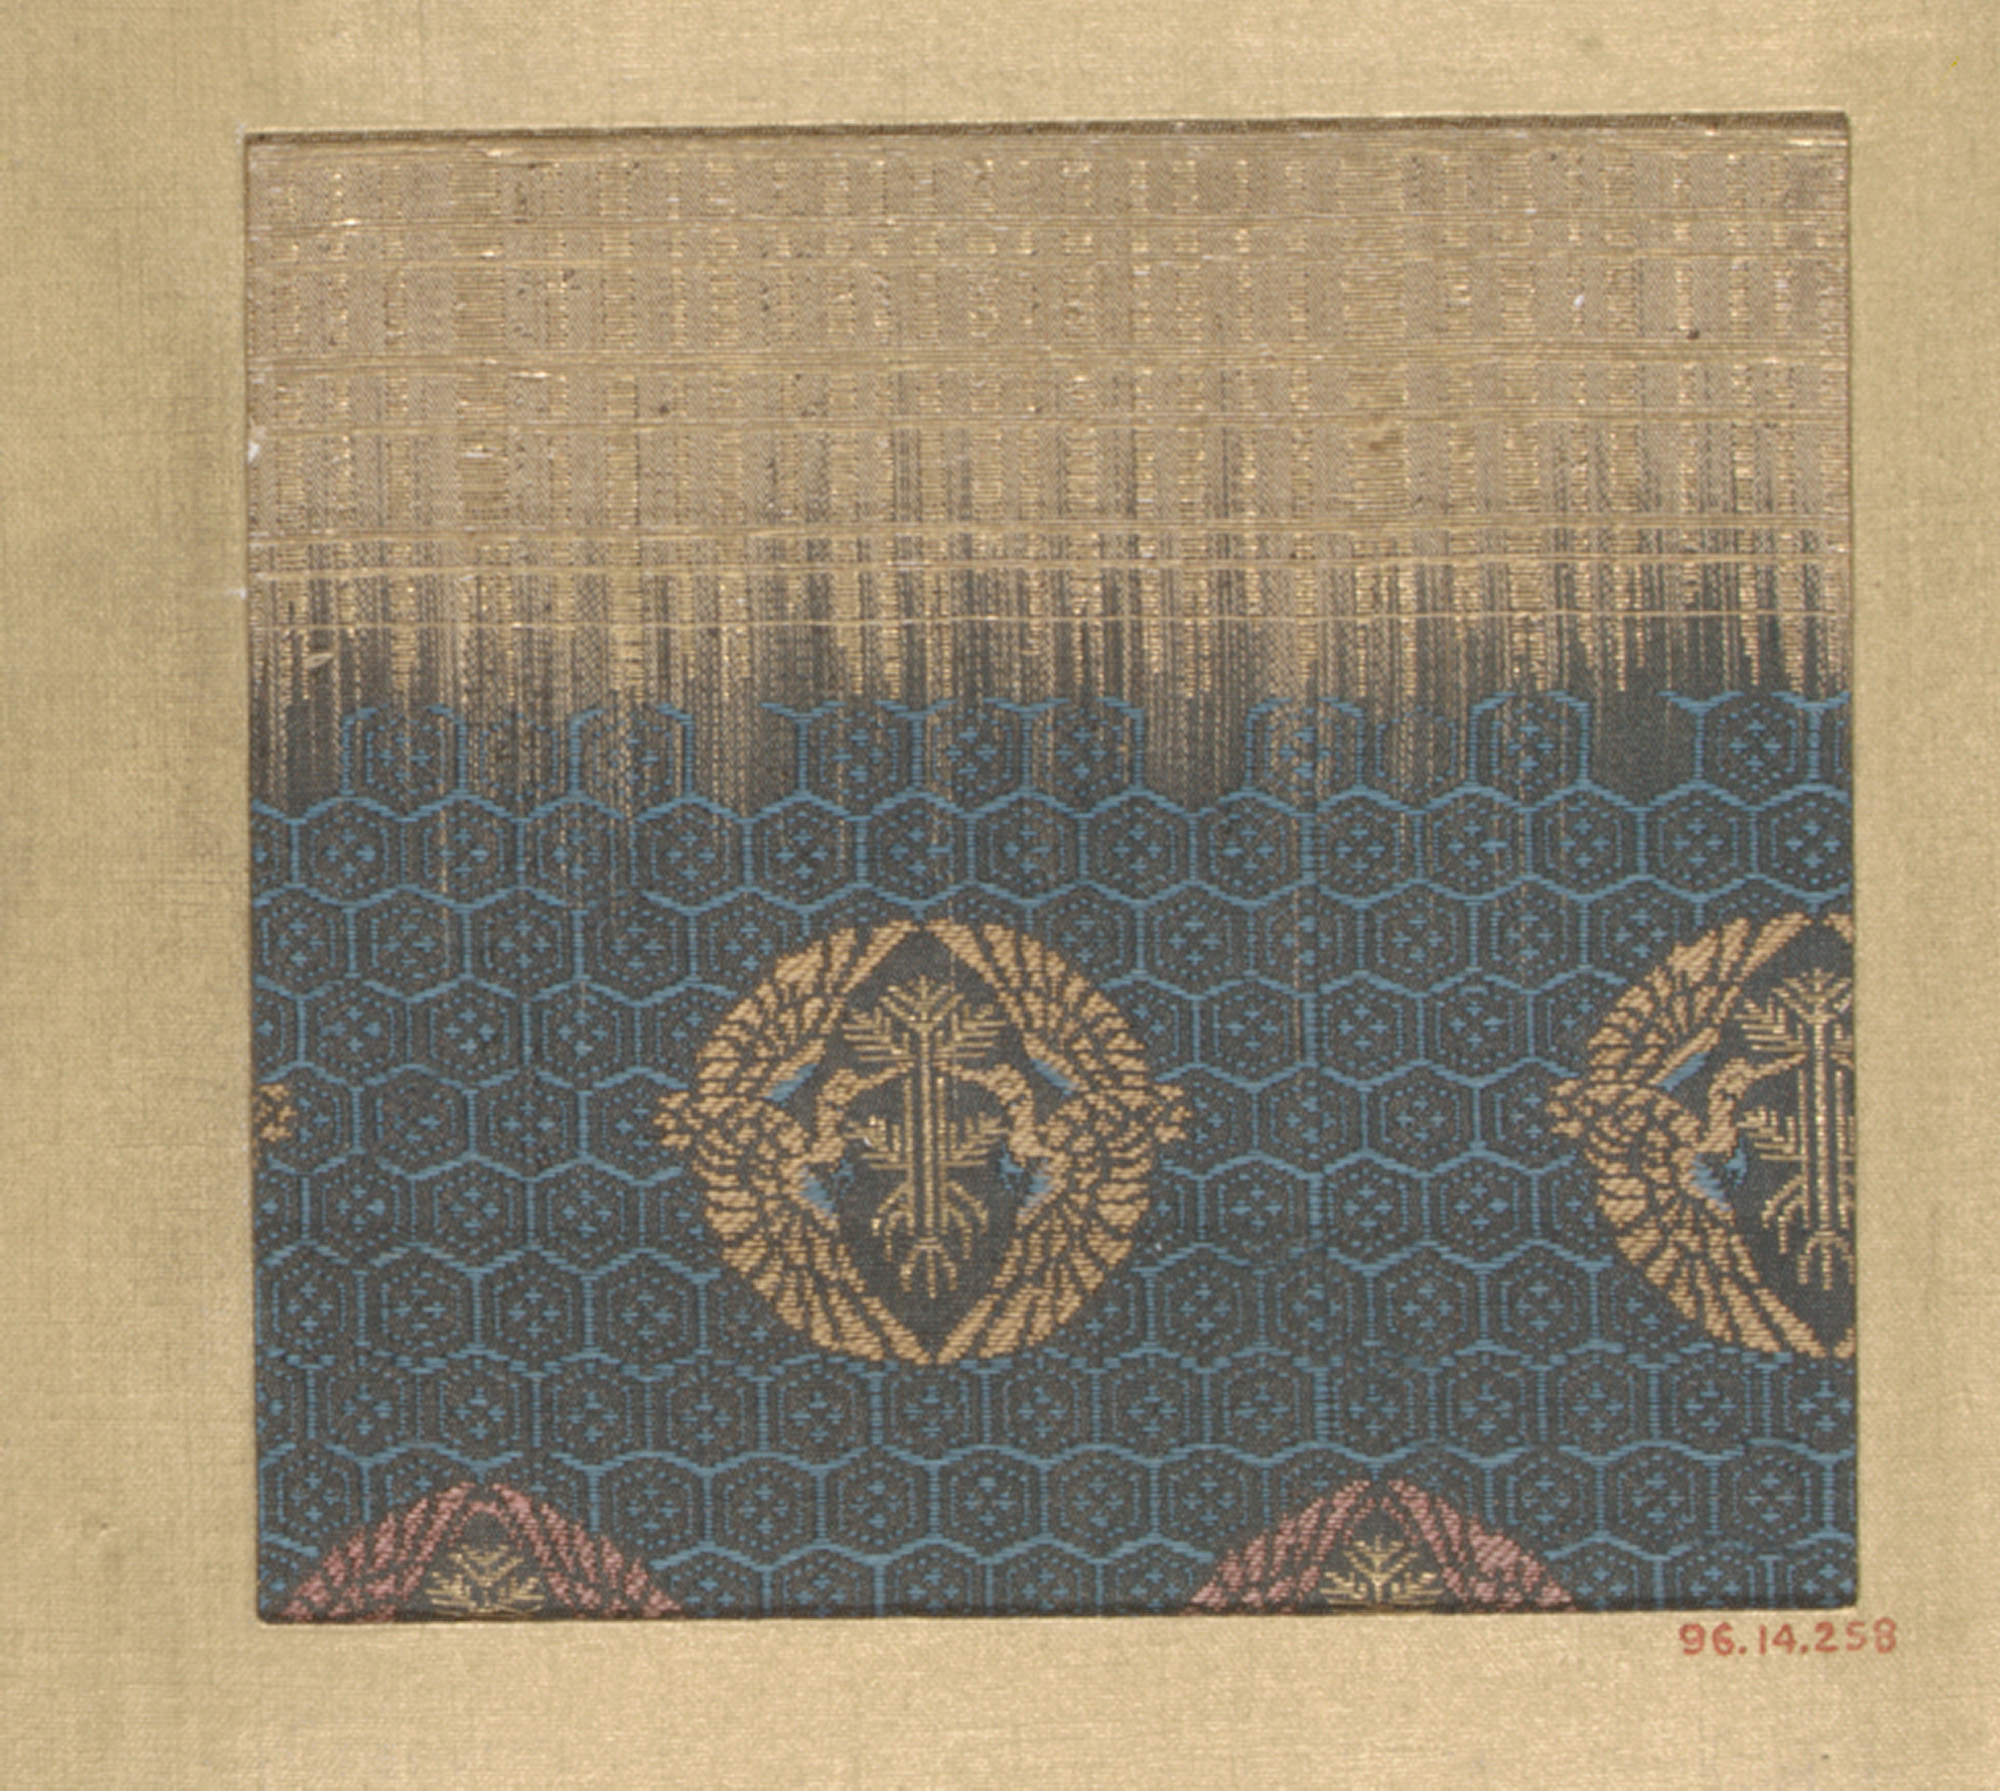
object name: piece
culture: japanese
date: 1701-1900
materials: silk